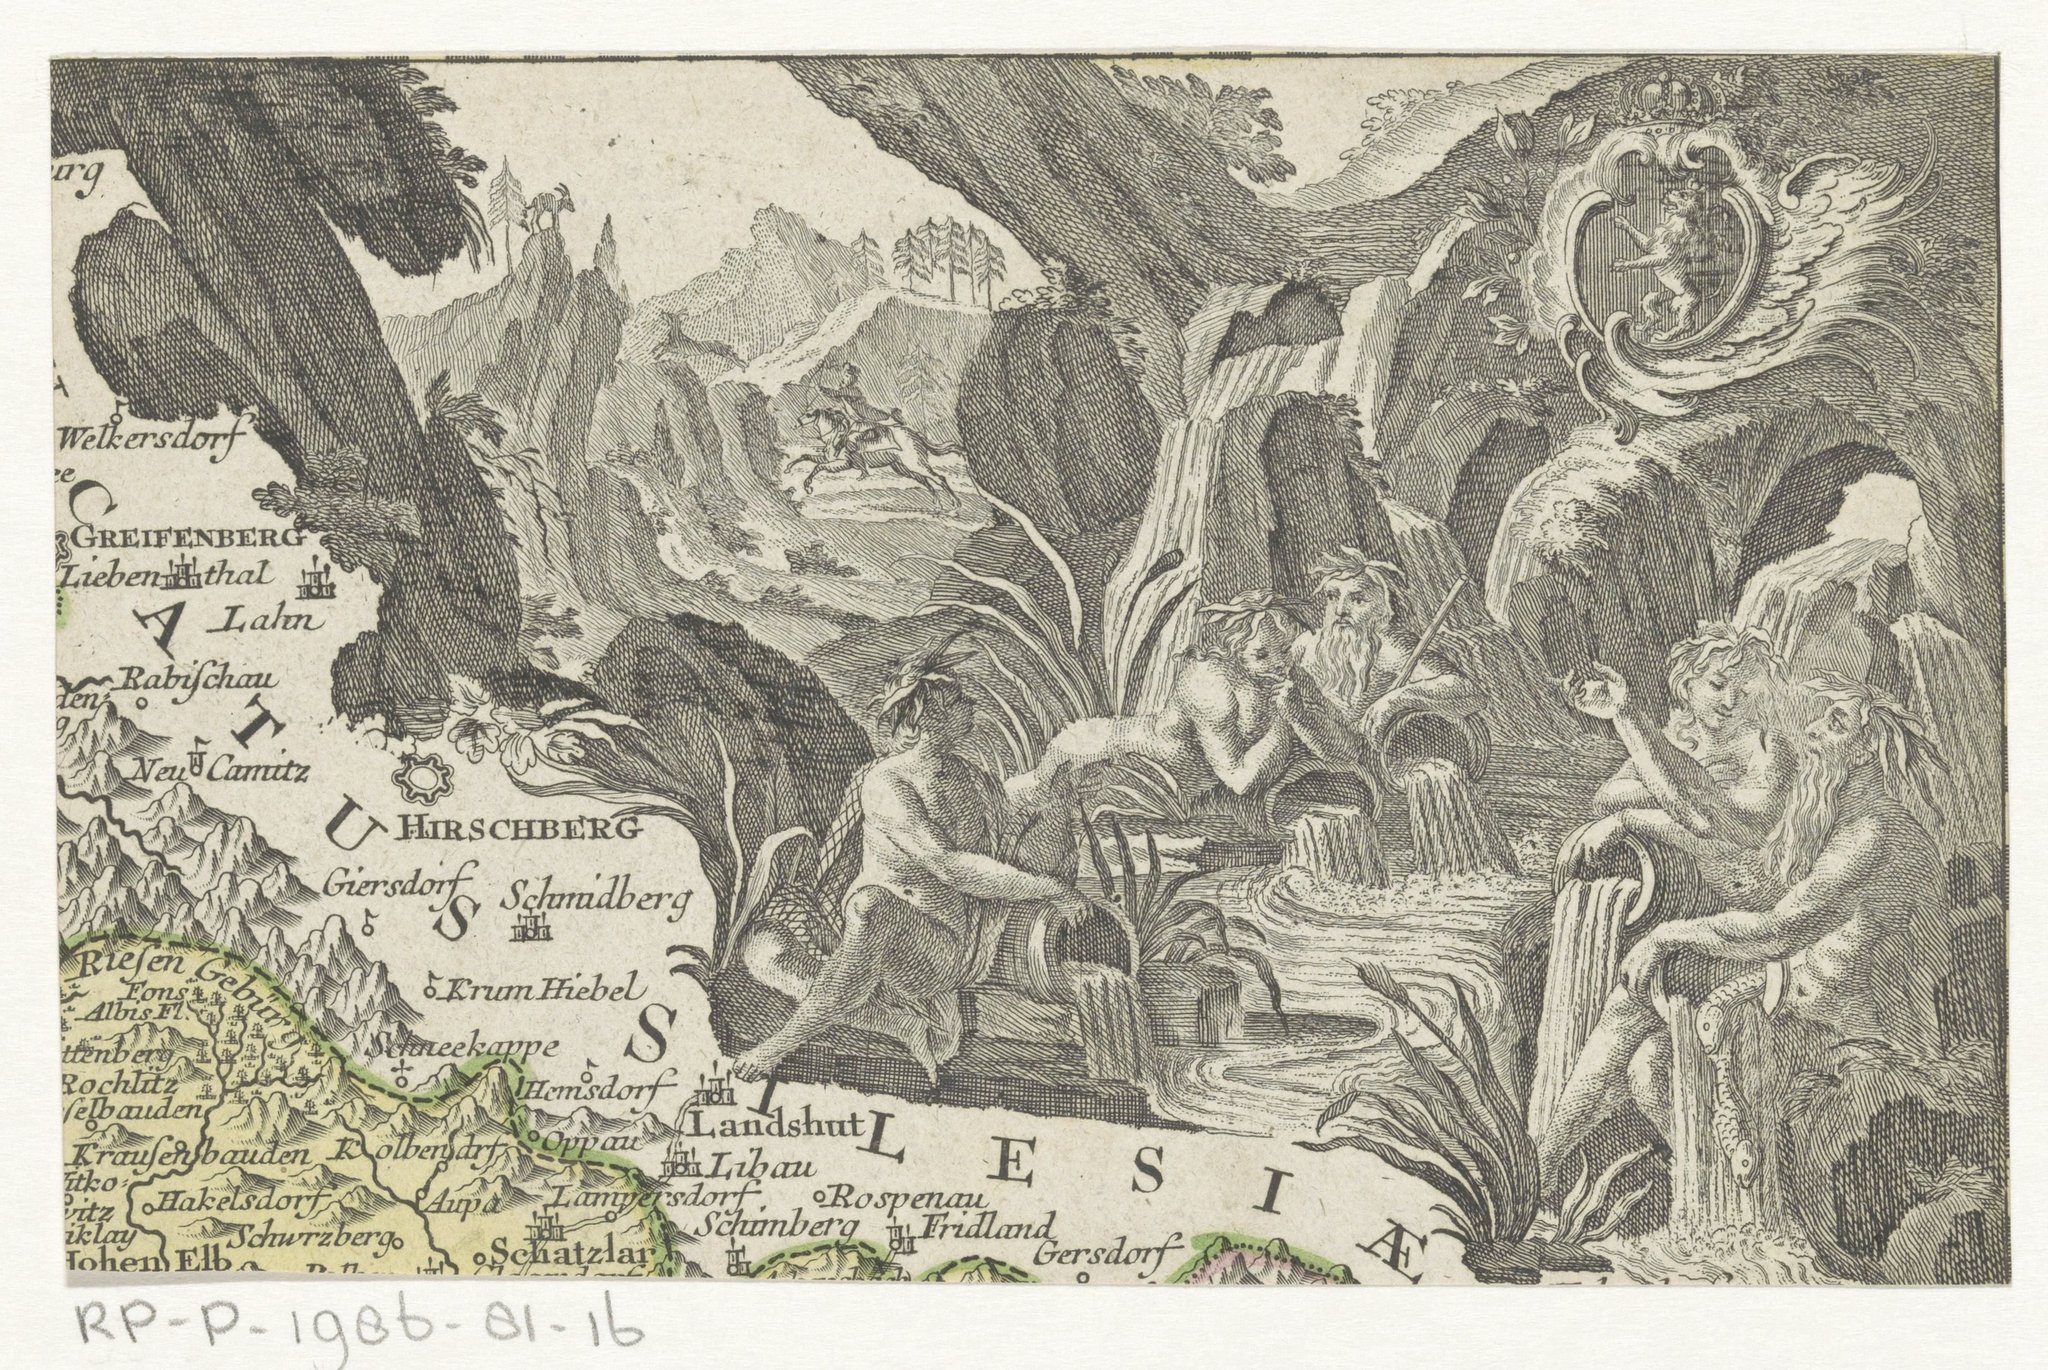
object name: print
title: Riviergoden en -godinnen in landschap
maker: Anonymous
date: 1700-1800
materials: paper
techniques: etching, hand coloring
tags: river-gods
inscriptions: collector's mark: Lugt 2228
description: Een groep van vijf riviergoden en -godinnen zit met waterkruiken in een berglandschap. Links in de achtergrond een ruiter te paard. Rechts boven een gekroonde cartouche met wapen met leeuw. Detail van een kaart waarop onder andere het gebied Silezië.